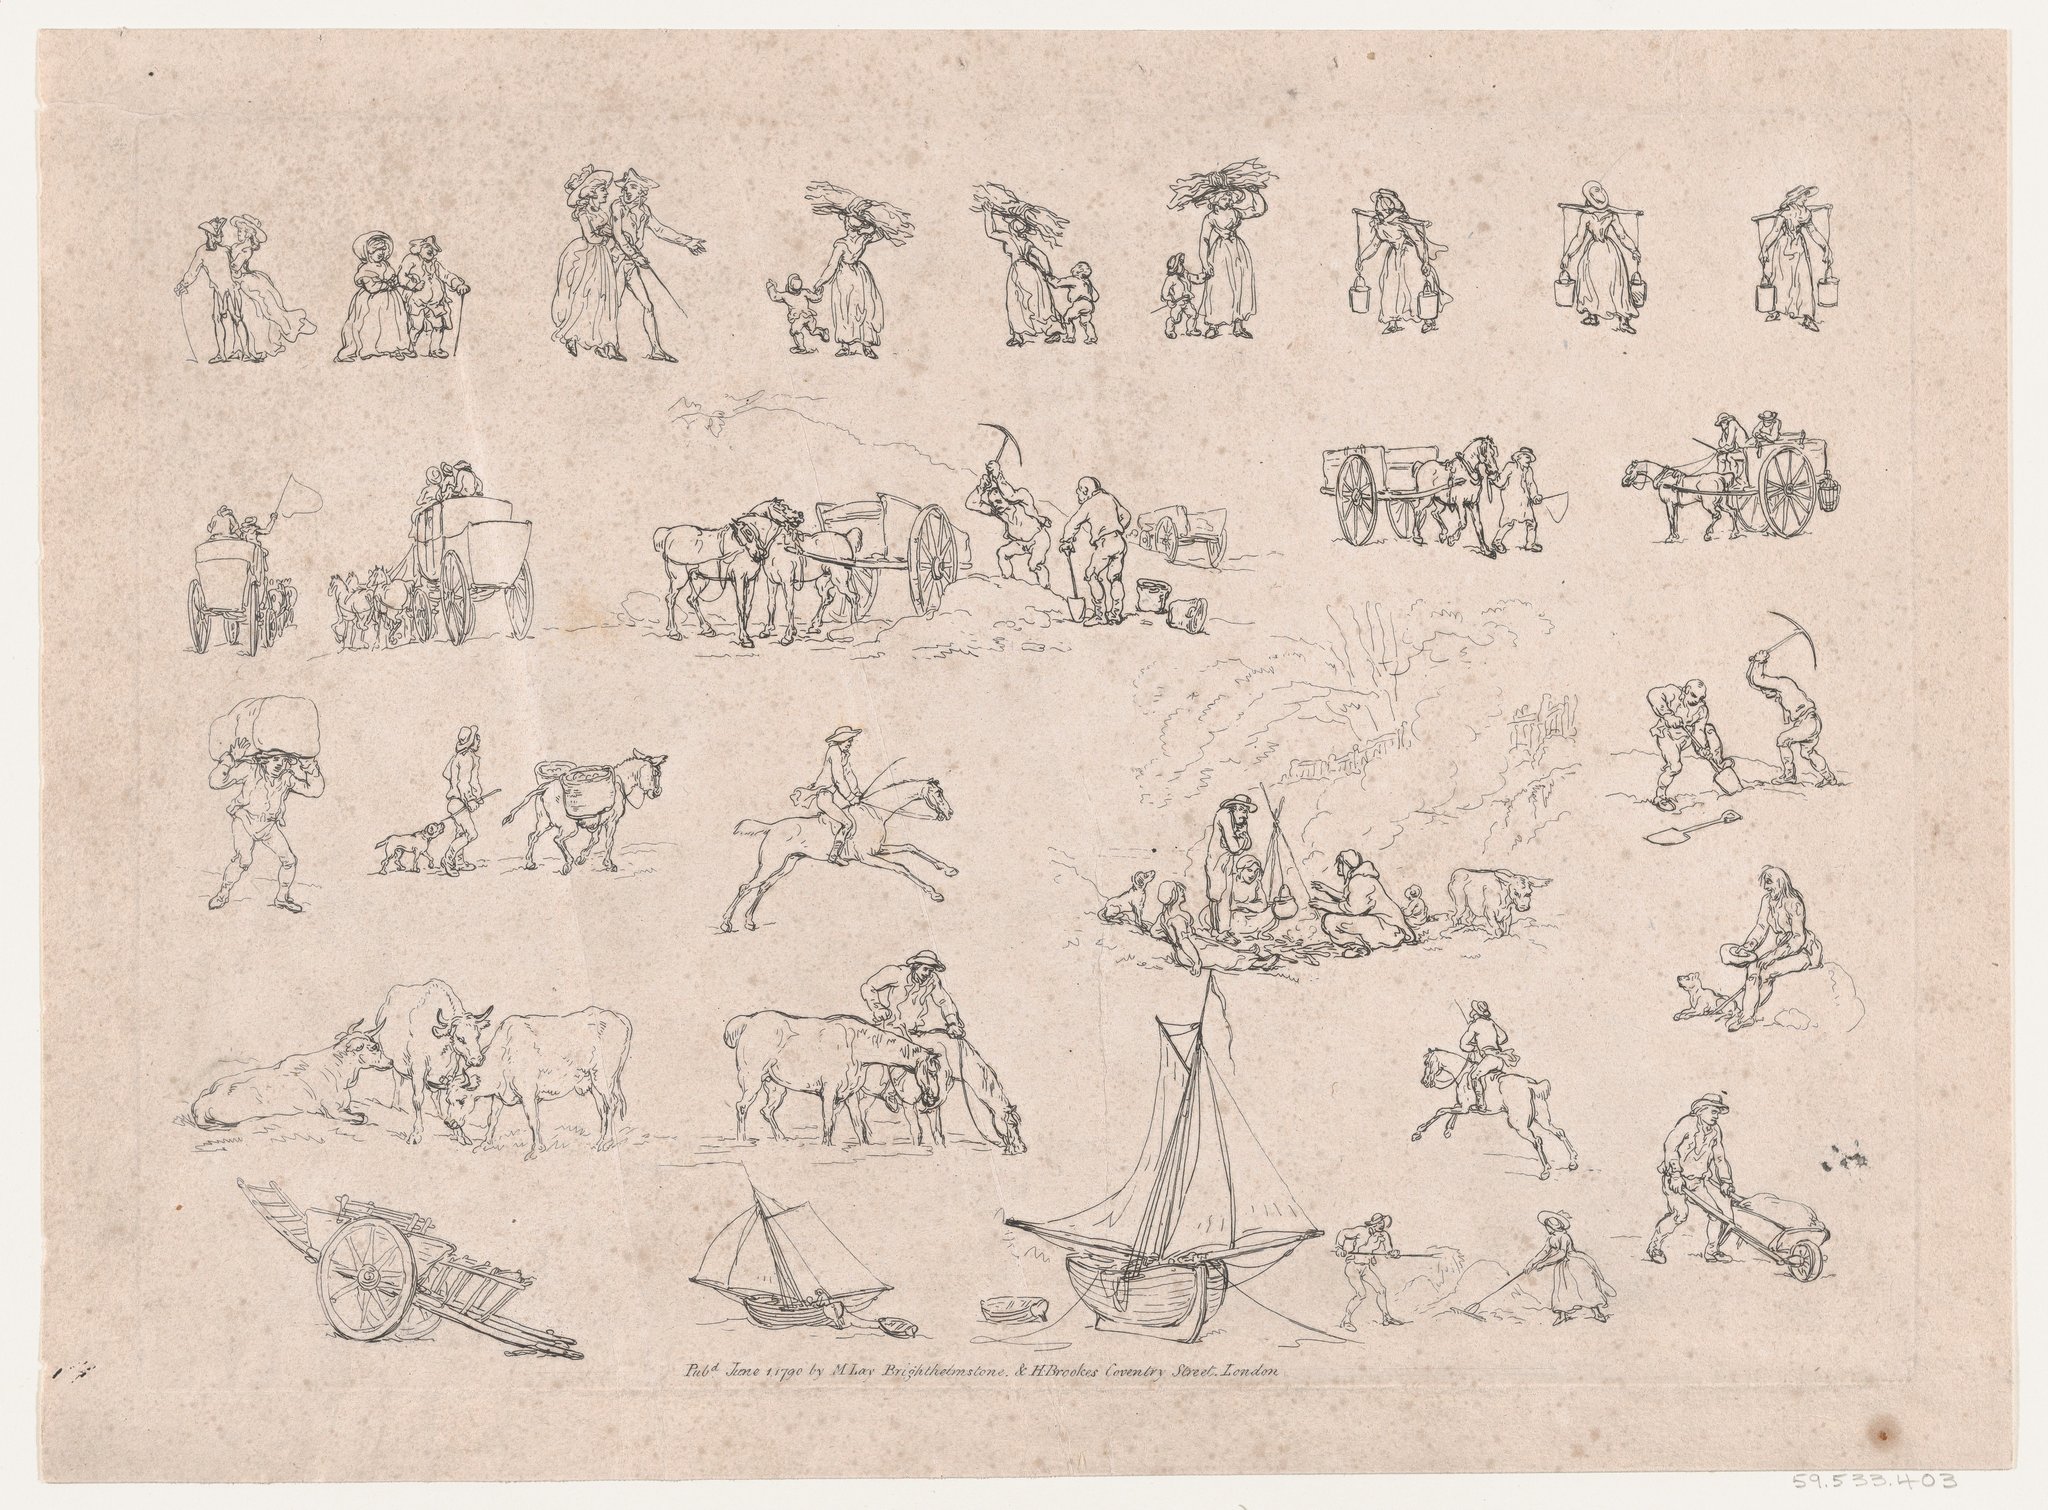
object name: print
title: Plate 2, Outlines of Figures, Landscapes and Cattle...for the Use of Learners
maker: thomas rowlandson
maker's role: artist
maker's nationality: british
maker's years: 1757-1827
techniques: etching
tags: men,women,horses,boats,carriages